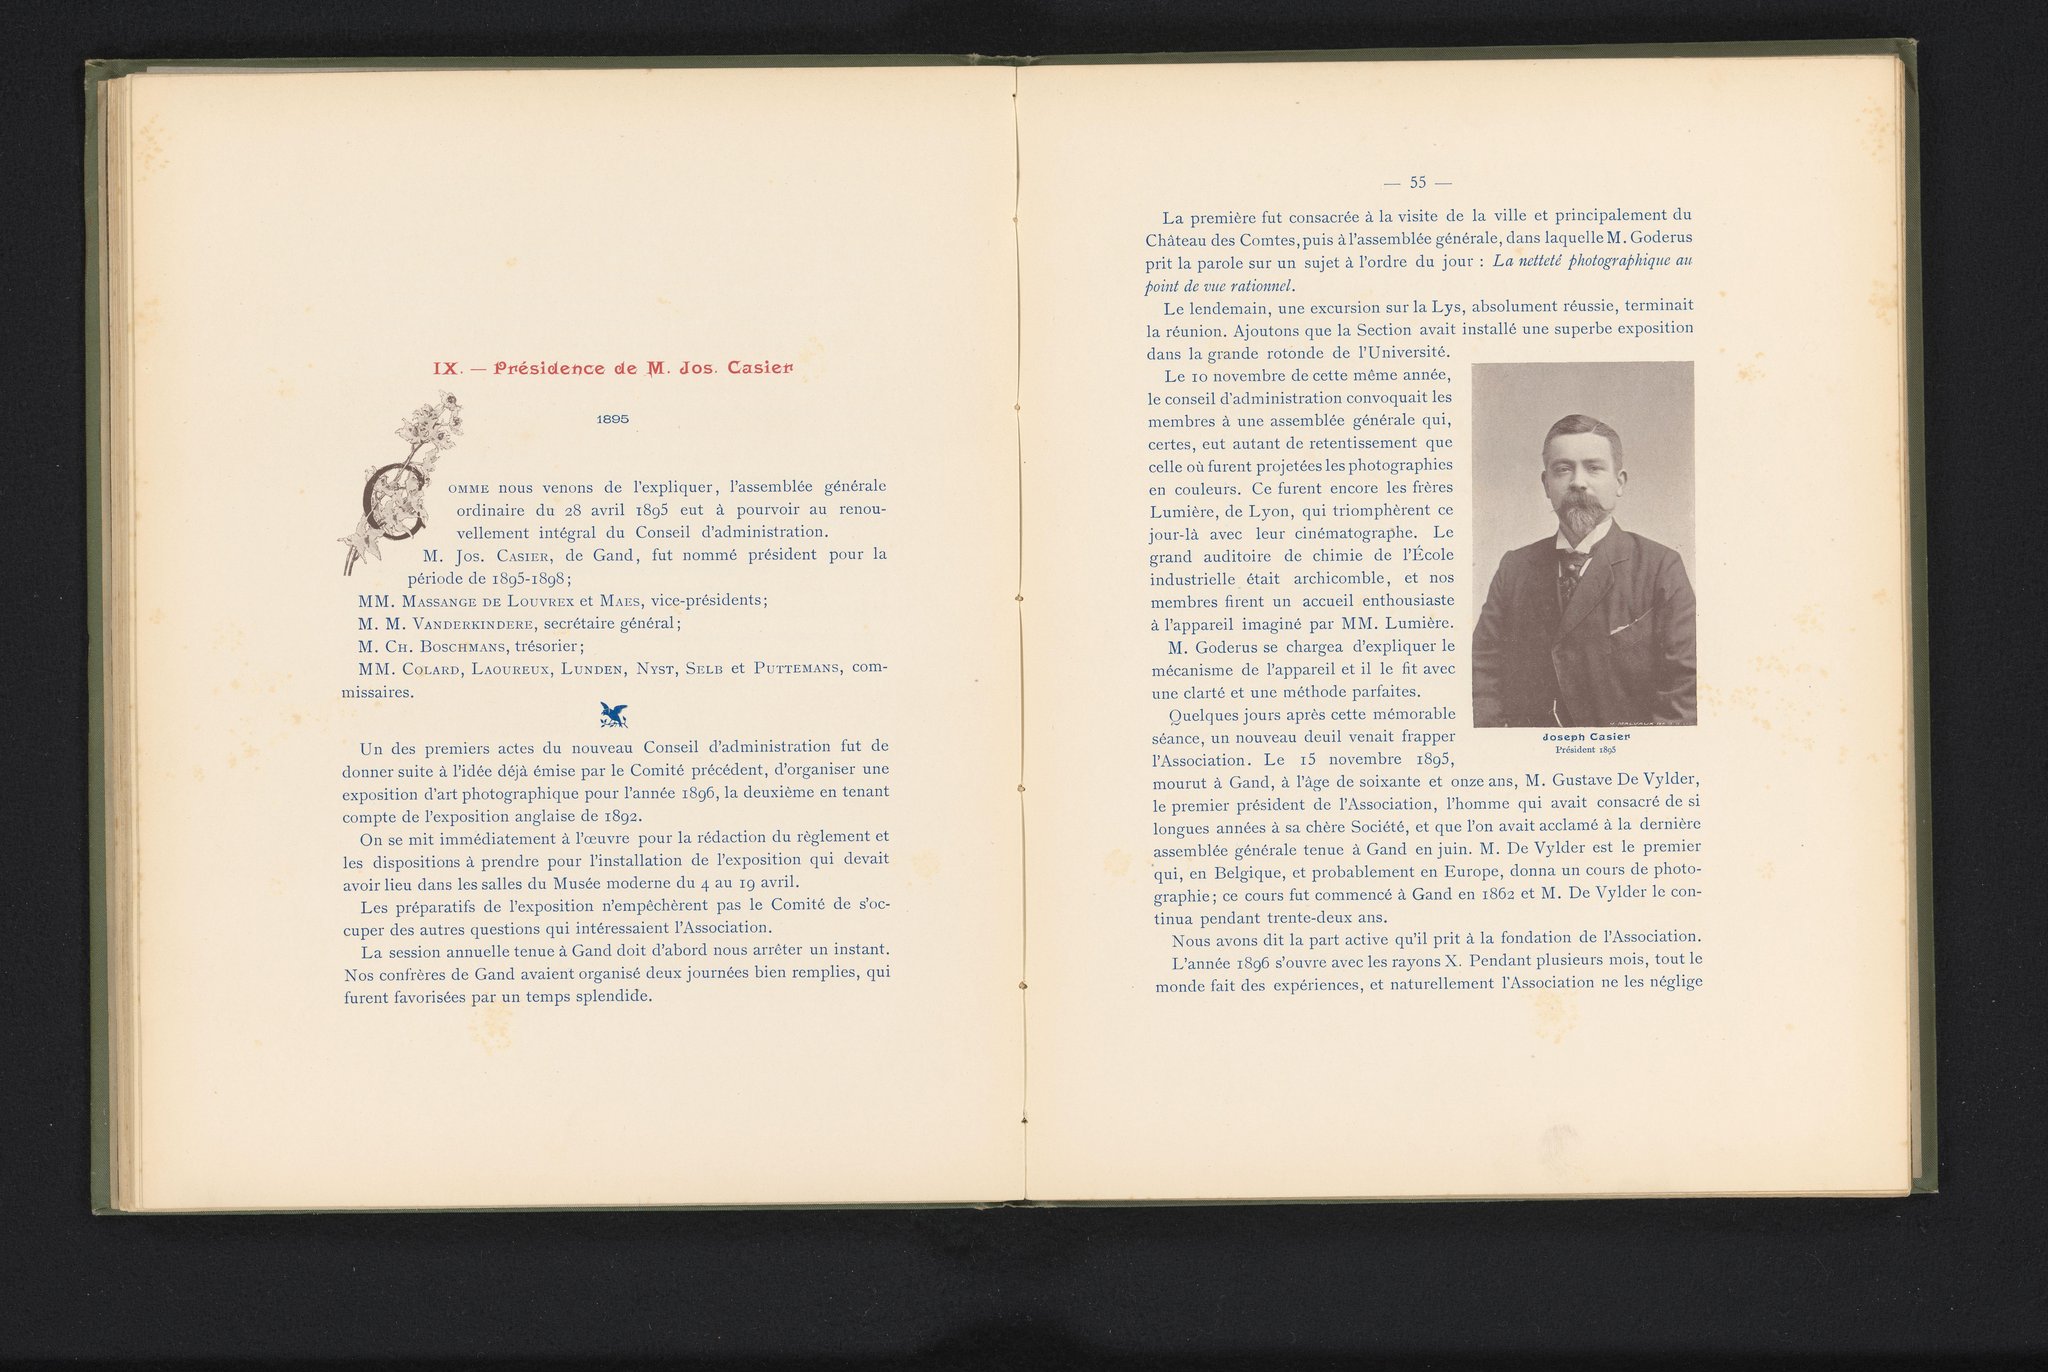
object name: photomechanical print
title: Joseph Casier, Président 1895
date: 1893-1898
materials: paper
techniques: autotype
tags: joseph casier, historical persons